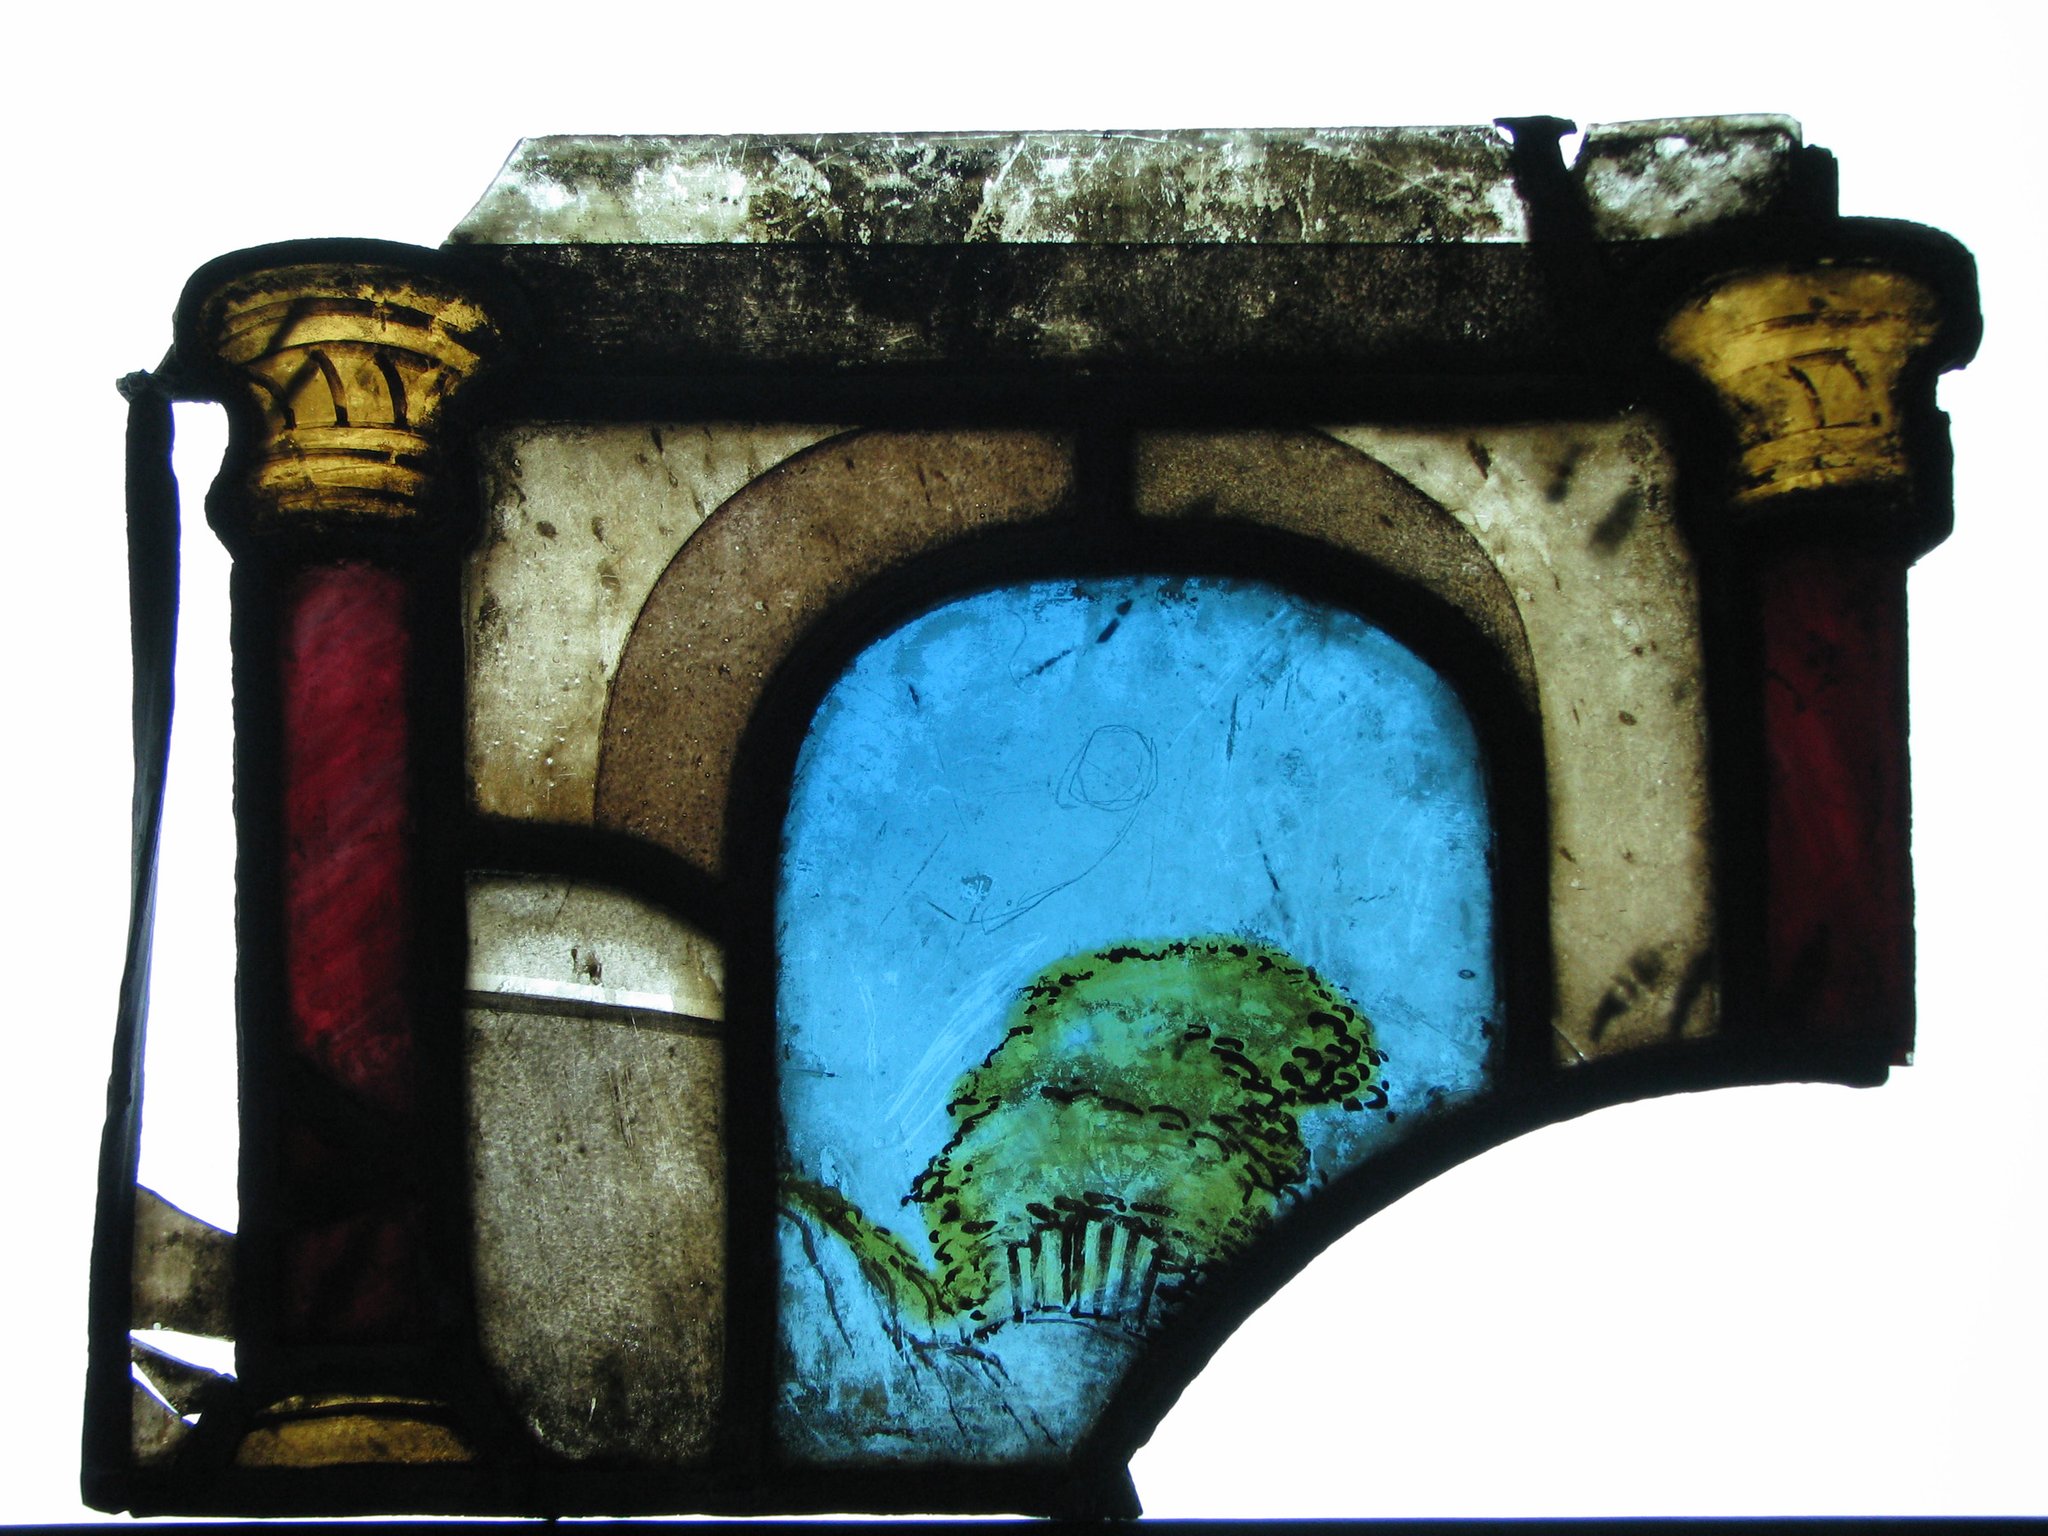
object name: fragment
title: Glass Fragment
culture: south netherlandish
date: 1501-1600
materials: glass